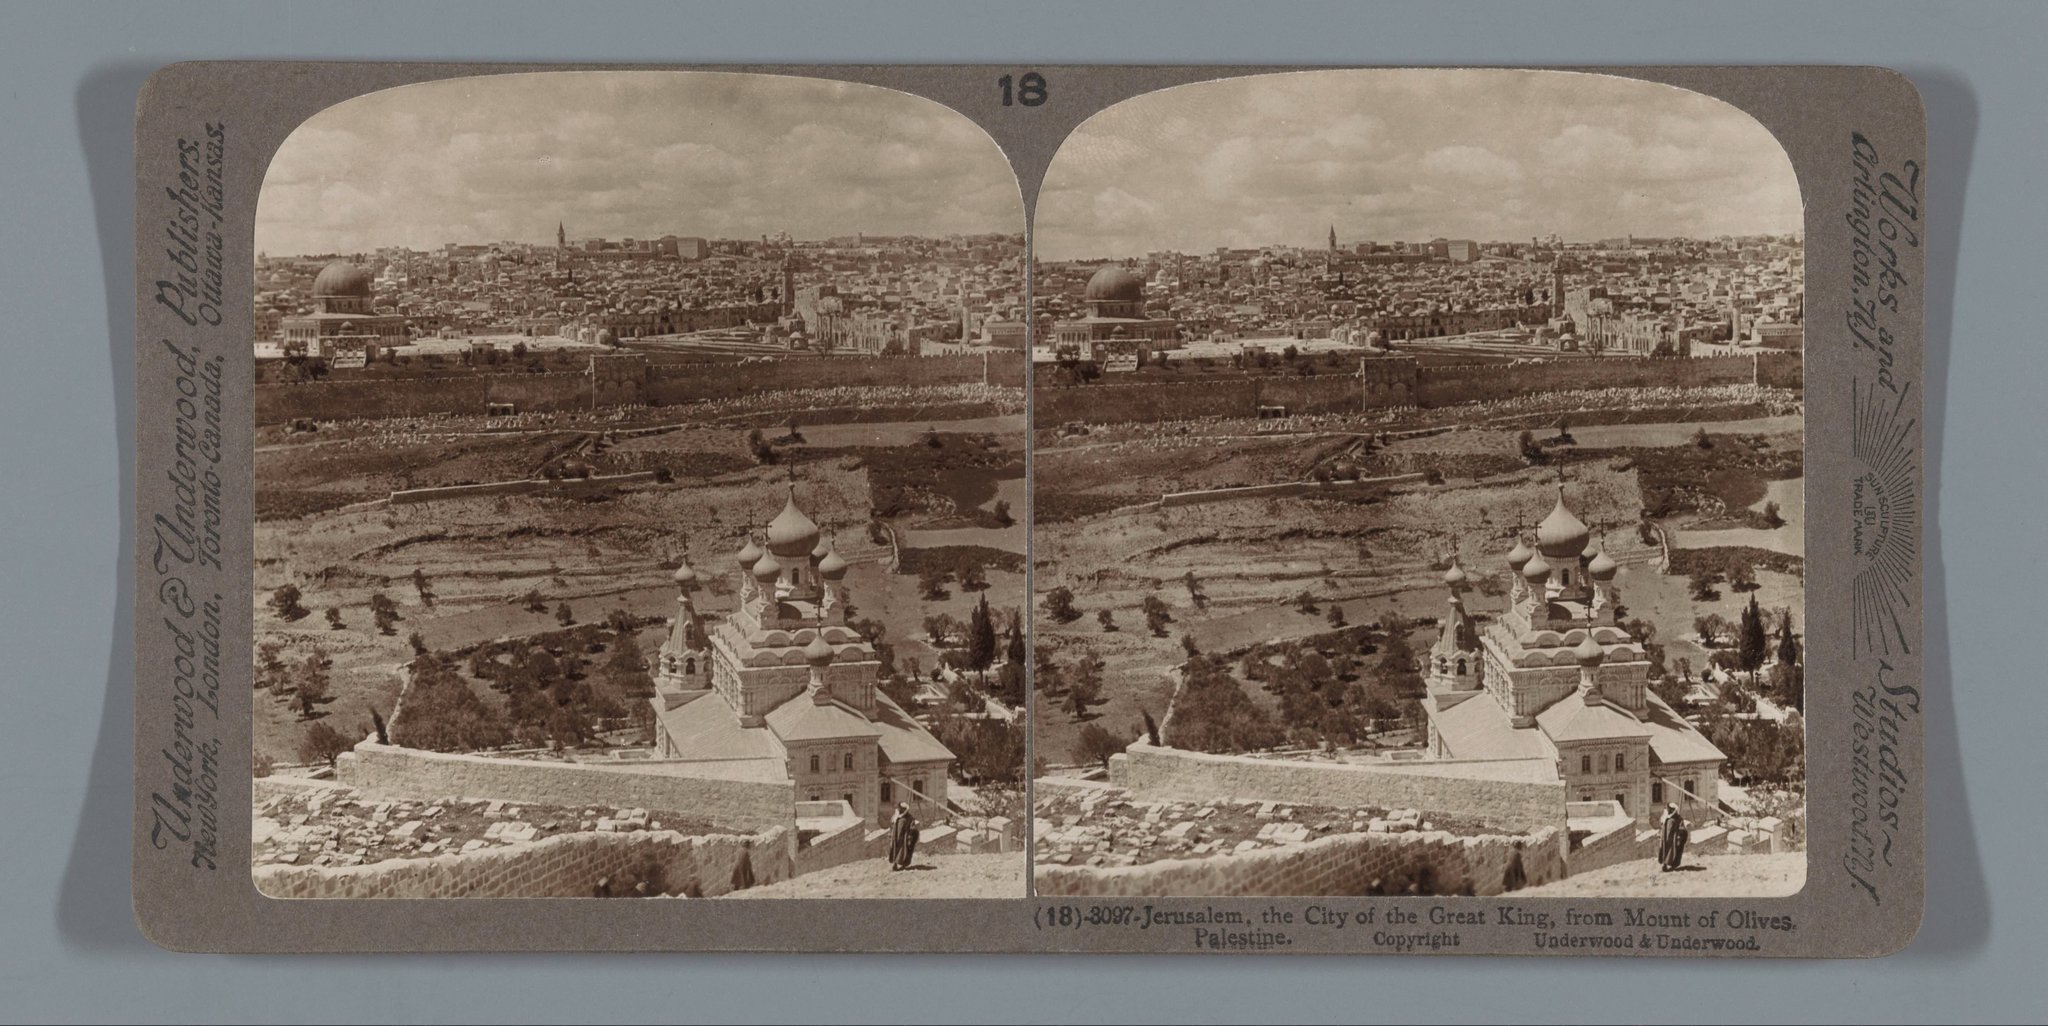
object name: stereograph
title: Jerusalem, the City of the Great King, from Mount of Olives. Palestine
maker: Anonymous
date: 1900-1905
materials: paper, cardboard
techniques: gelatin silver print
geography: new york city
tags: city-view in general; 'veduta'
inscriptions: inscription, number: ‘(18)-3097-’, number: ‘3097’, number: ‘18’, copyright notice: ‘Copyright Underwood & Underwood.’, inscription: ‘Works and Studios ~/ Arlington, N.J. Westwood, N.J.’, inscription: ‘We are standing on the Mount of Olives (...) From Notes of Travel No. 11, copyright 1904 by Underwood & Underwood.’